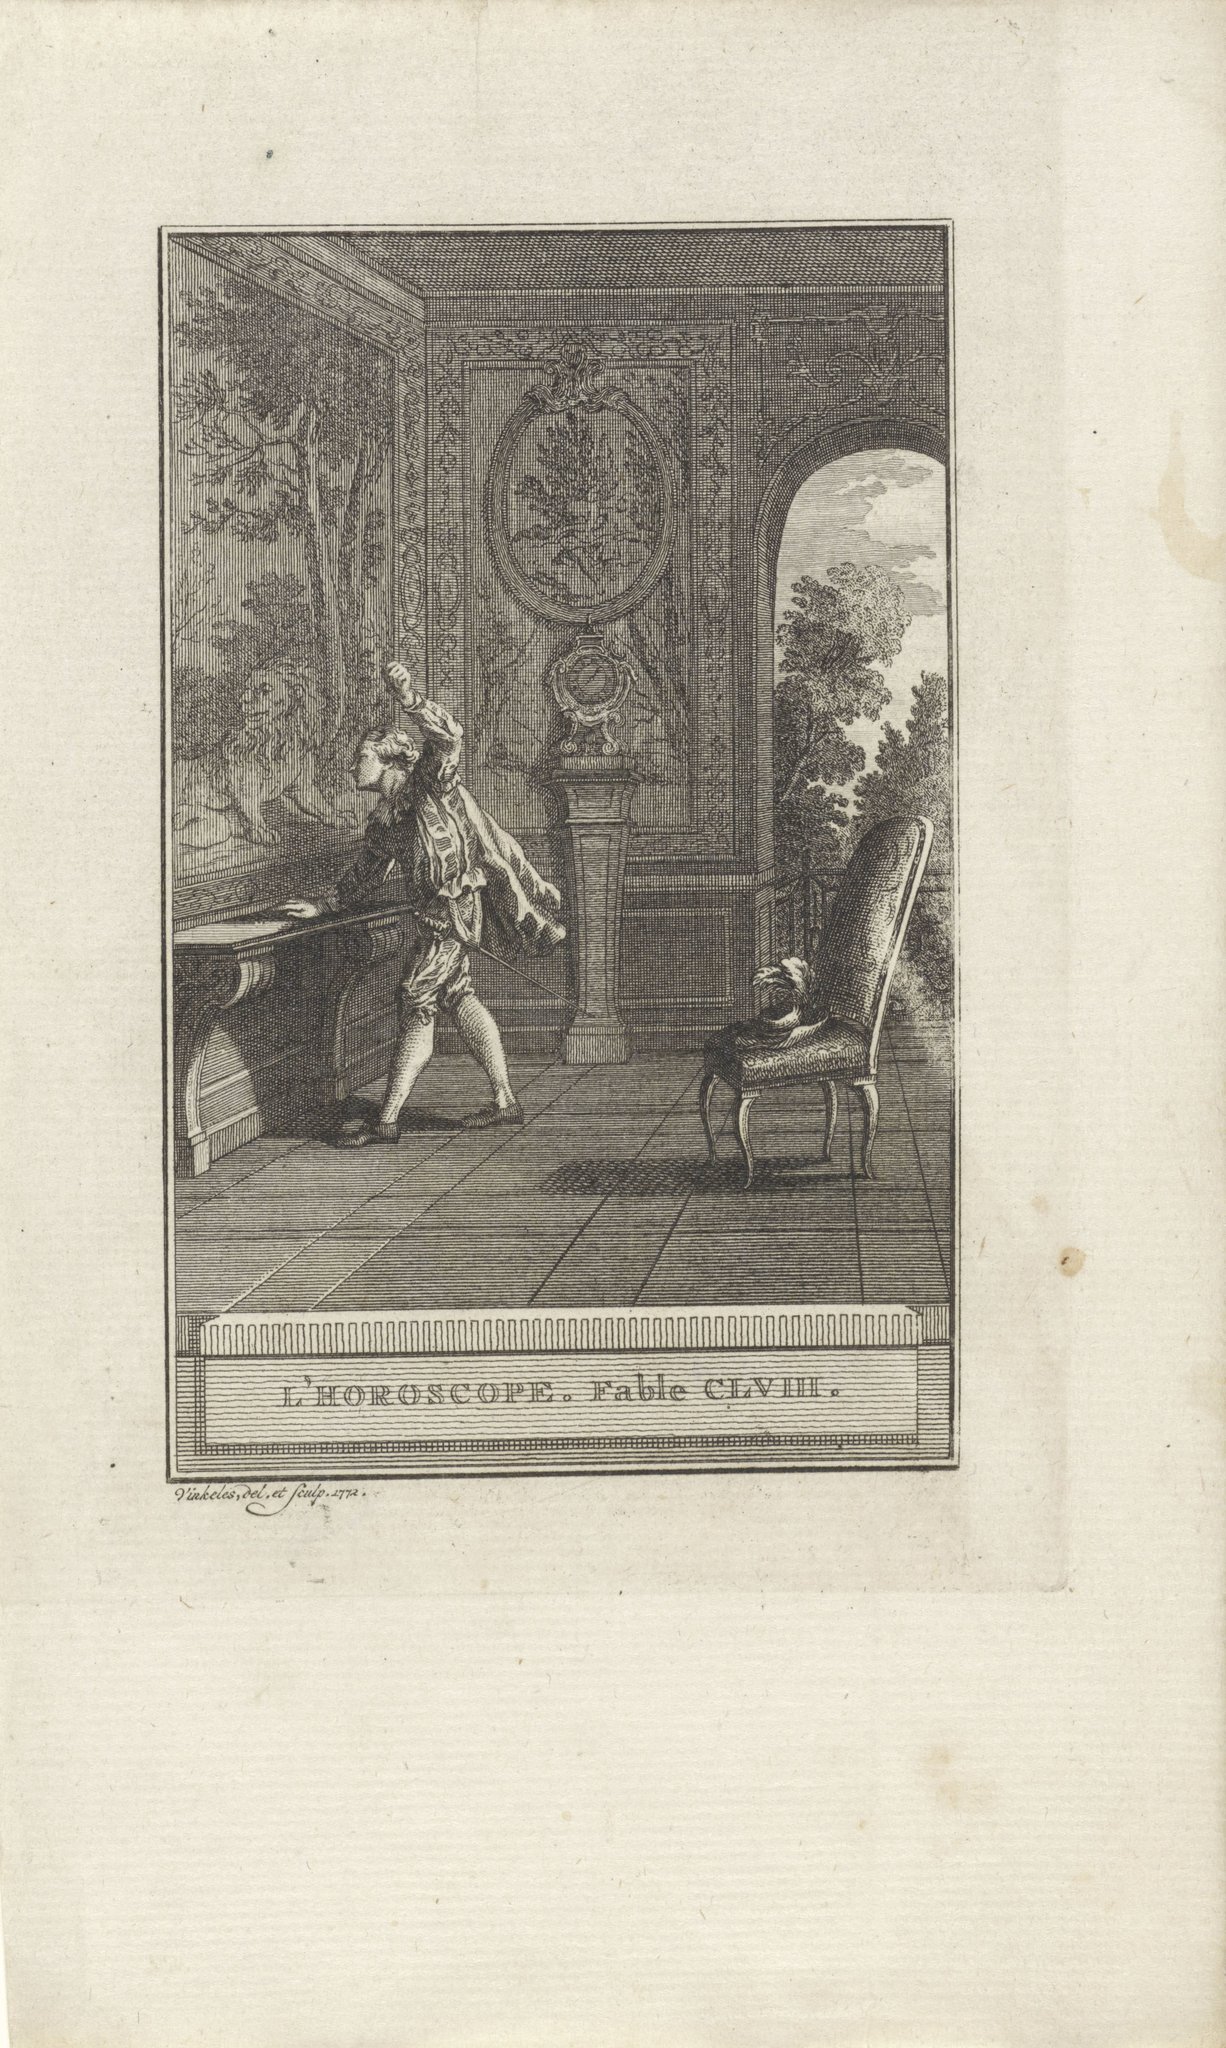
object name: print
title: Horoscoop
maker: reinier vinkeles (i)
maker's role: draughtsman, print maker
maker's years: 1741-1816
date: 1772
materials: paper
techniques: etching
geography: amsterdam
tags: arm raised, with fist, picture, painting, beasts of prey, predatory animals: lion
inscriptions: collector's mark: Lugt 2228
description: Prent waarschijnlijk gebruikt als illustratie in een of meerdere edities van: La Fontaine, Jean de. Fables choisies. Amsterdam: J. van Gulik, 1802.